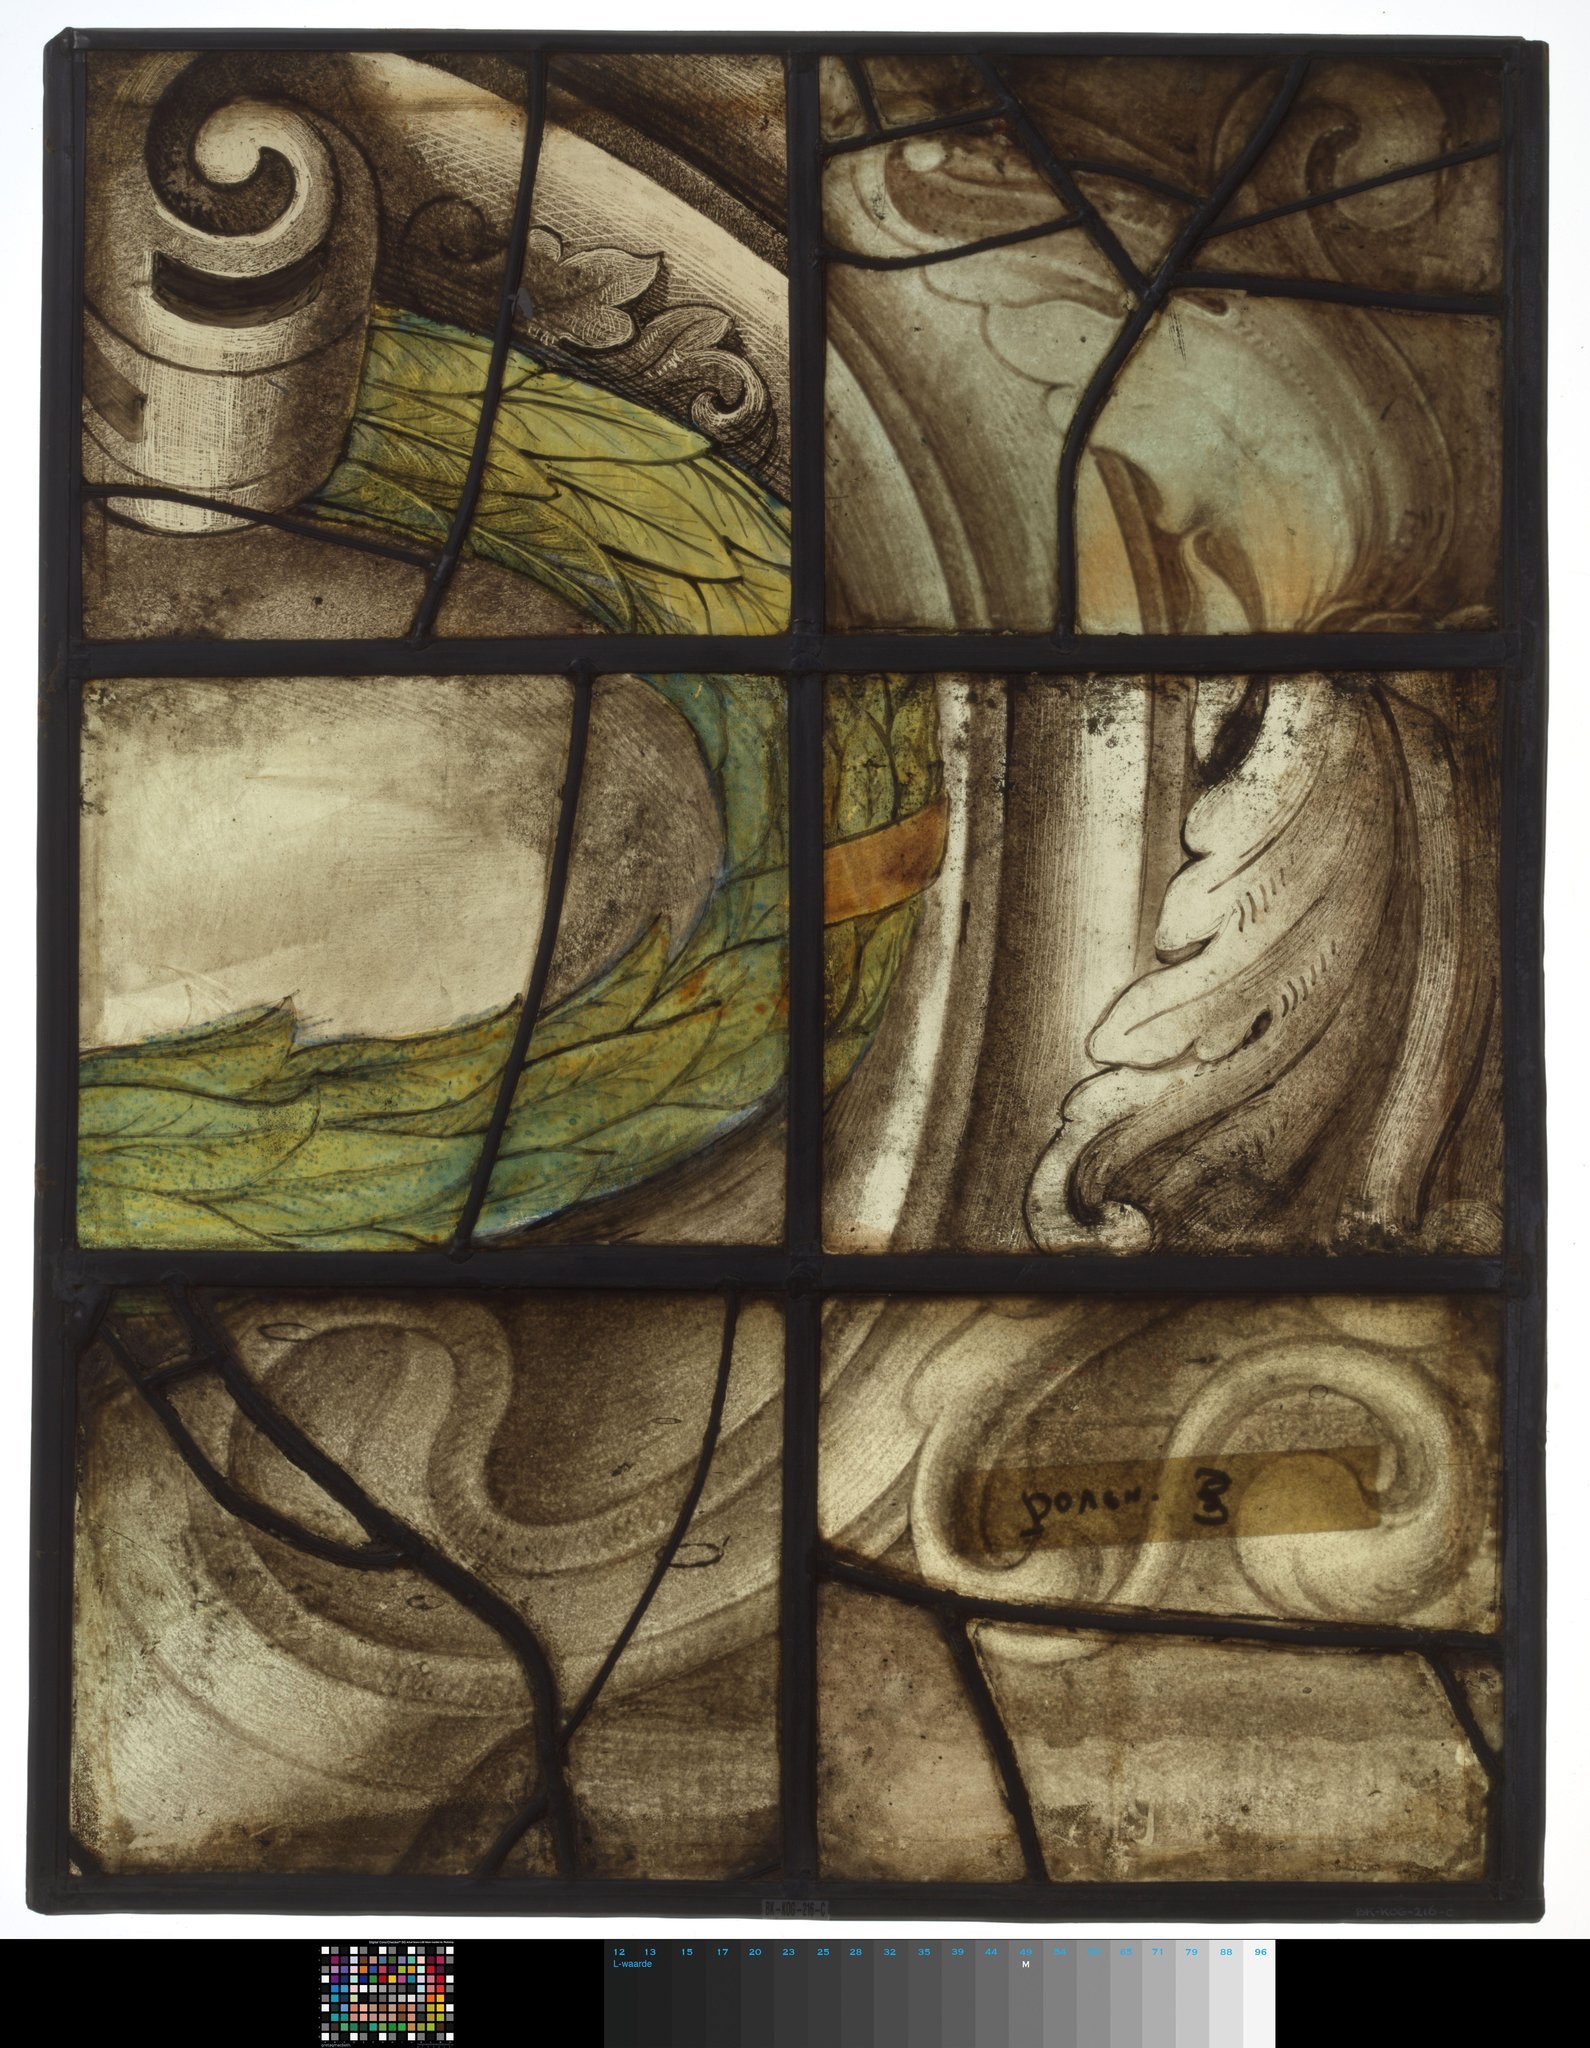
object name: light window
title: Ruit met het wapen van Alkmaar met onderschrift "Alkmaria Victrix 1573"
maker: Anonymous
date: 1573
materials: glass, lead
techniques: leading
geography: netherlands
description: Ruit, glas-in-lood, bestaande uit zestien afzonderlijke panelen die tezamen het wapen van Alkmaar laten zien. Onderschrift: ALKMARIA VICTRIX. Gedateerd 1573.